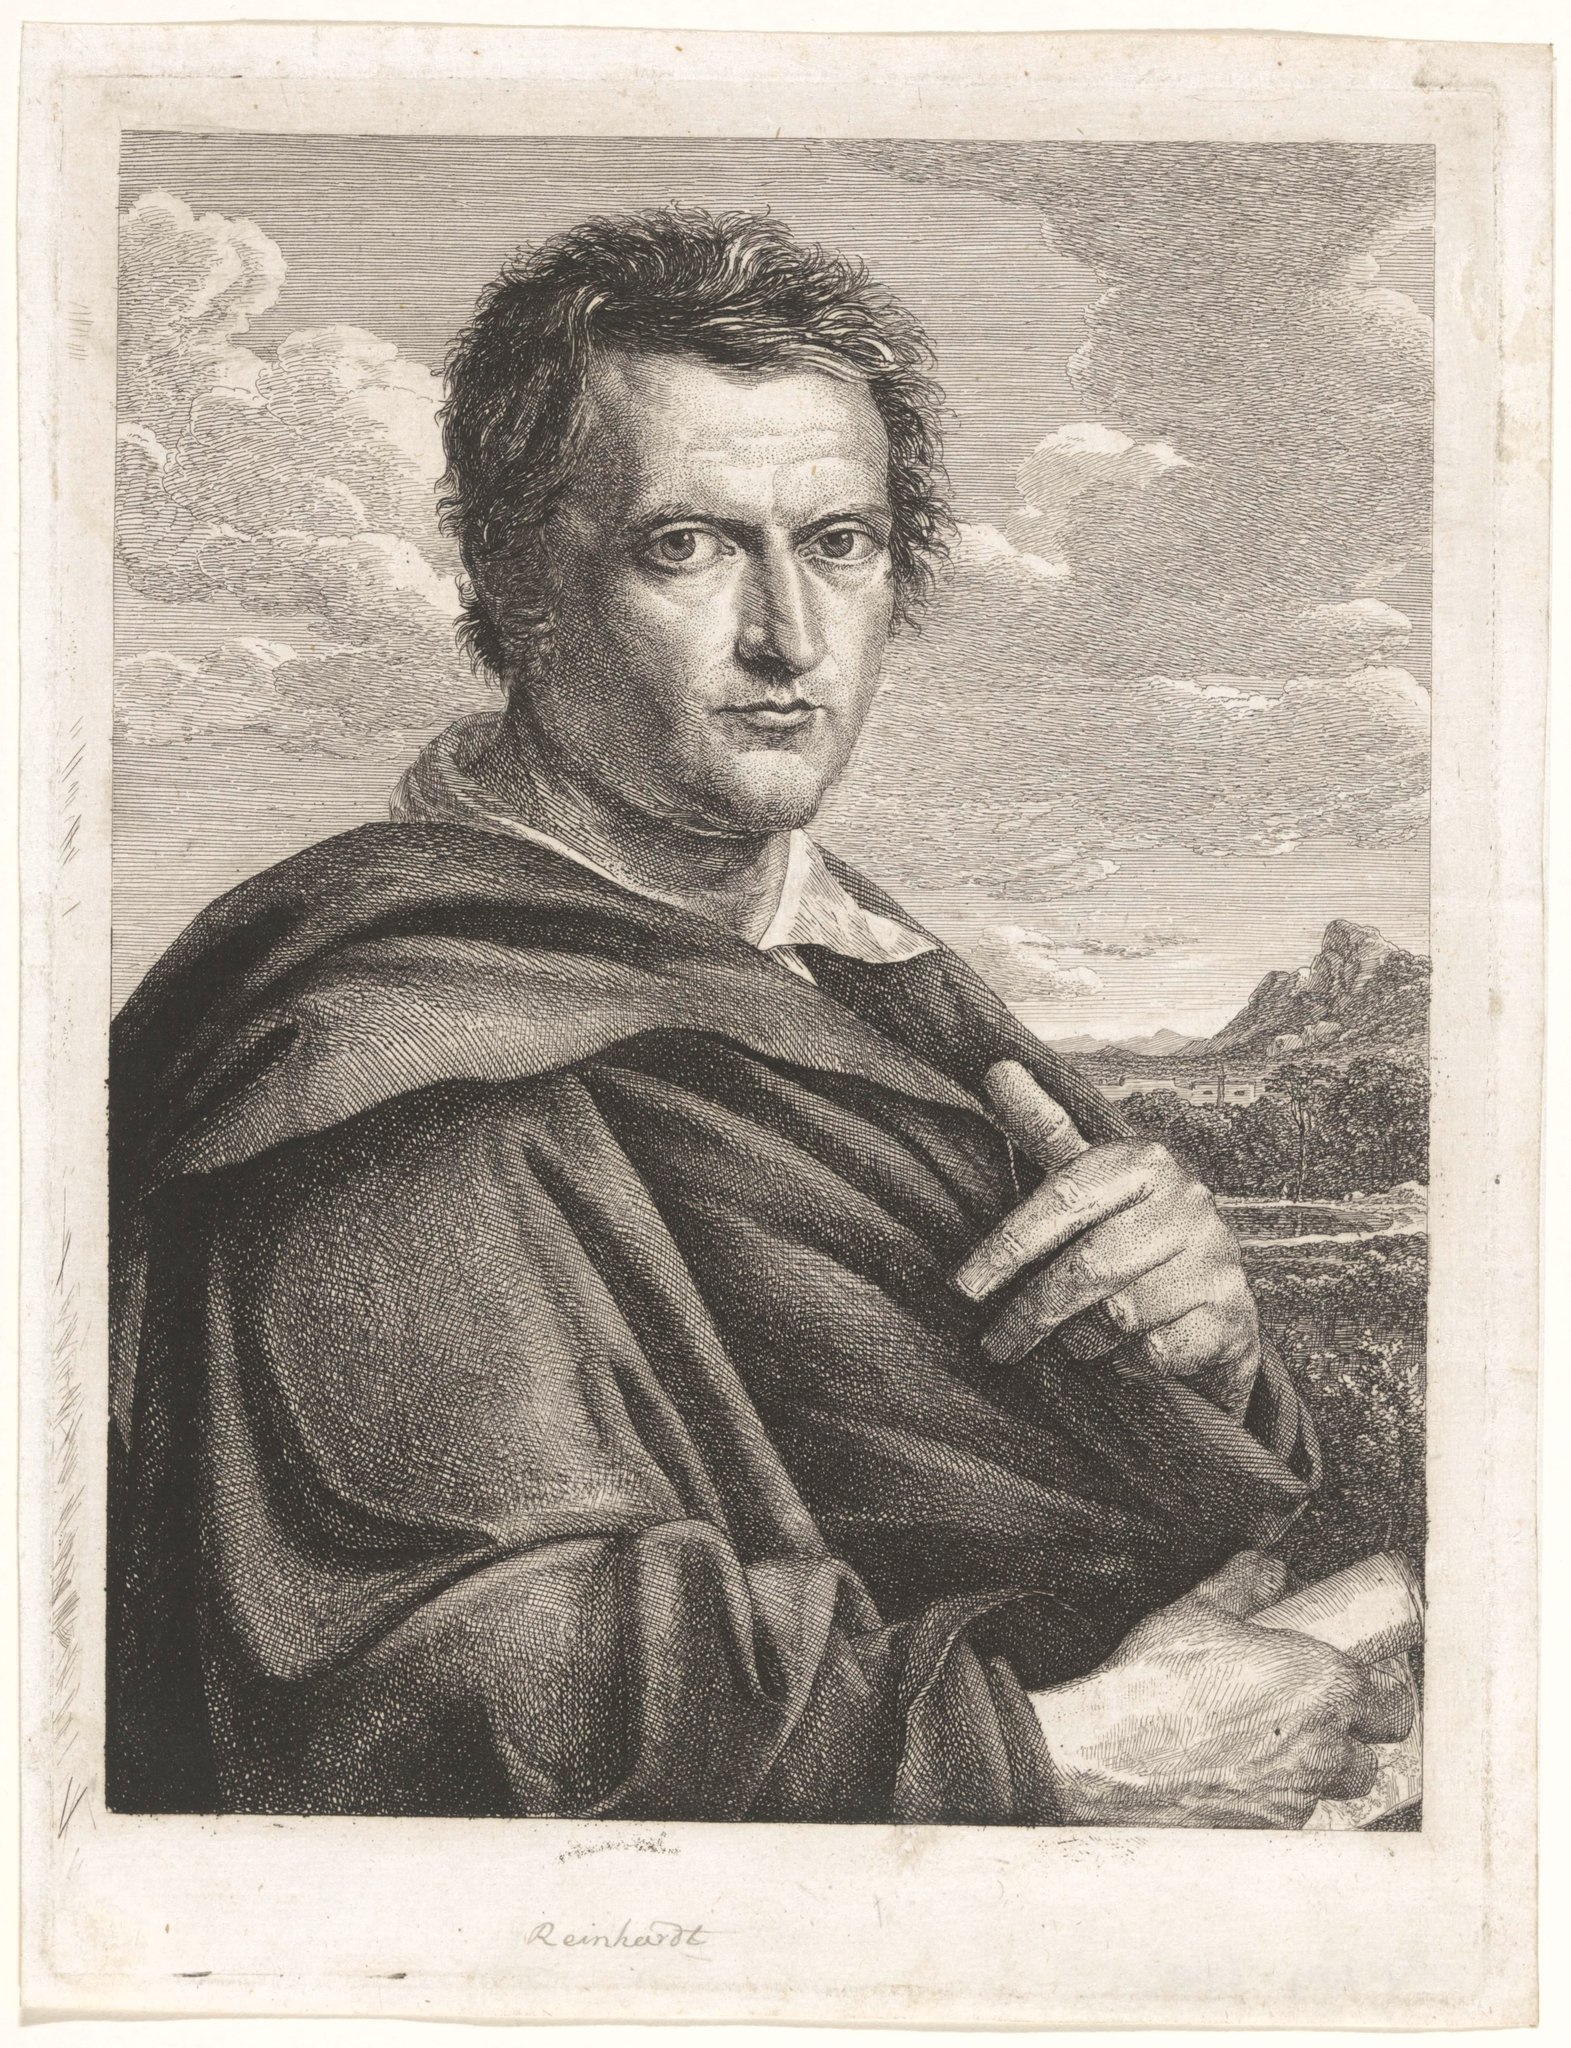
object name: print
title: Portret van de schilder Johann Christian Reinhart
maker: josé de madrazo y agudo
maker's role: painter, print maker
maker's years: 1781-1859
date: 1811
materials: paper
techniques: etching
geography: rome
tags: rome, print maker, johann christian reinhart, portrait, self-portrait of painter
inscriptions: collector's mark: Lugt 2228, collector's mark: Lugt 2760